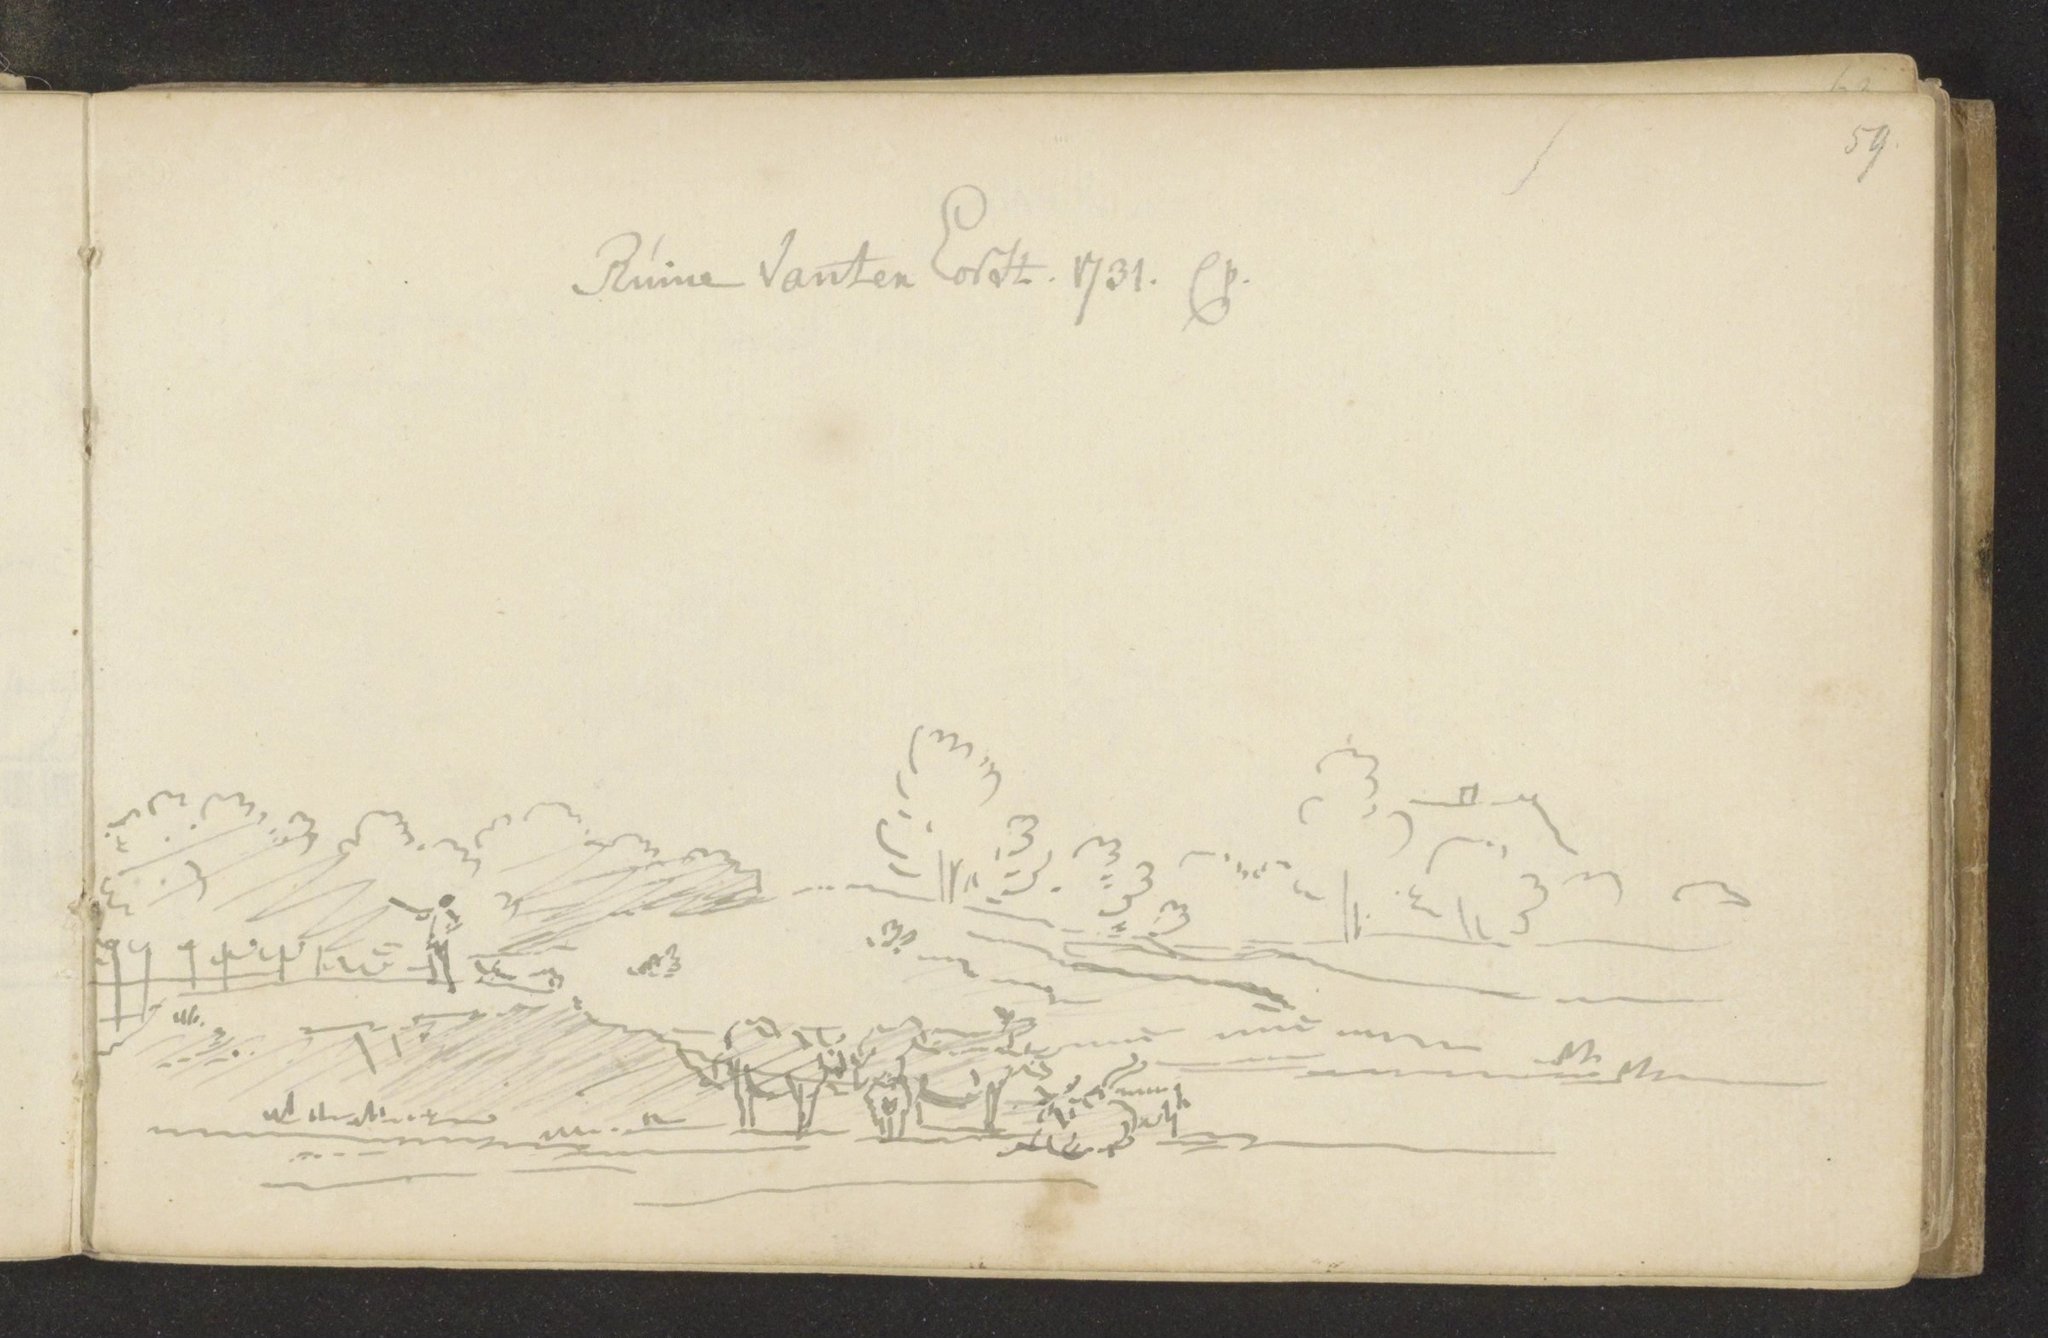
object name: sketchbook leaf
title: Ruïne van kasteel Ter Horst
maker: abraham de haen (ii)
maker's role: draughtsman, print maker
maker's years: 1707-1748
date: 1731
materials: ink, paper, pencil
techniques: pen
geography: rhenen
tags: landscape with ruins, rhenen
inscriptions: date and inscription: ‘Ruine Van ter Horst.1731.cp.’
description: Blad 59 recto uit een schetsboek met 78 bladen.